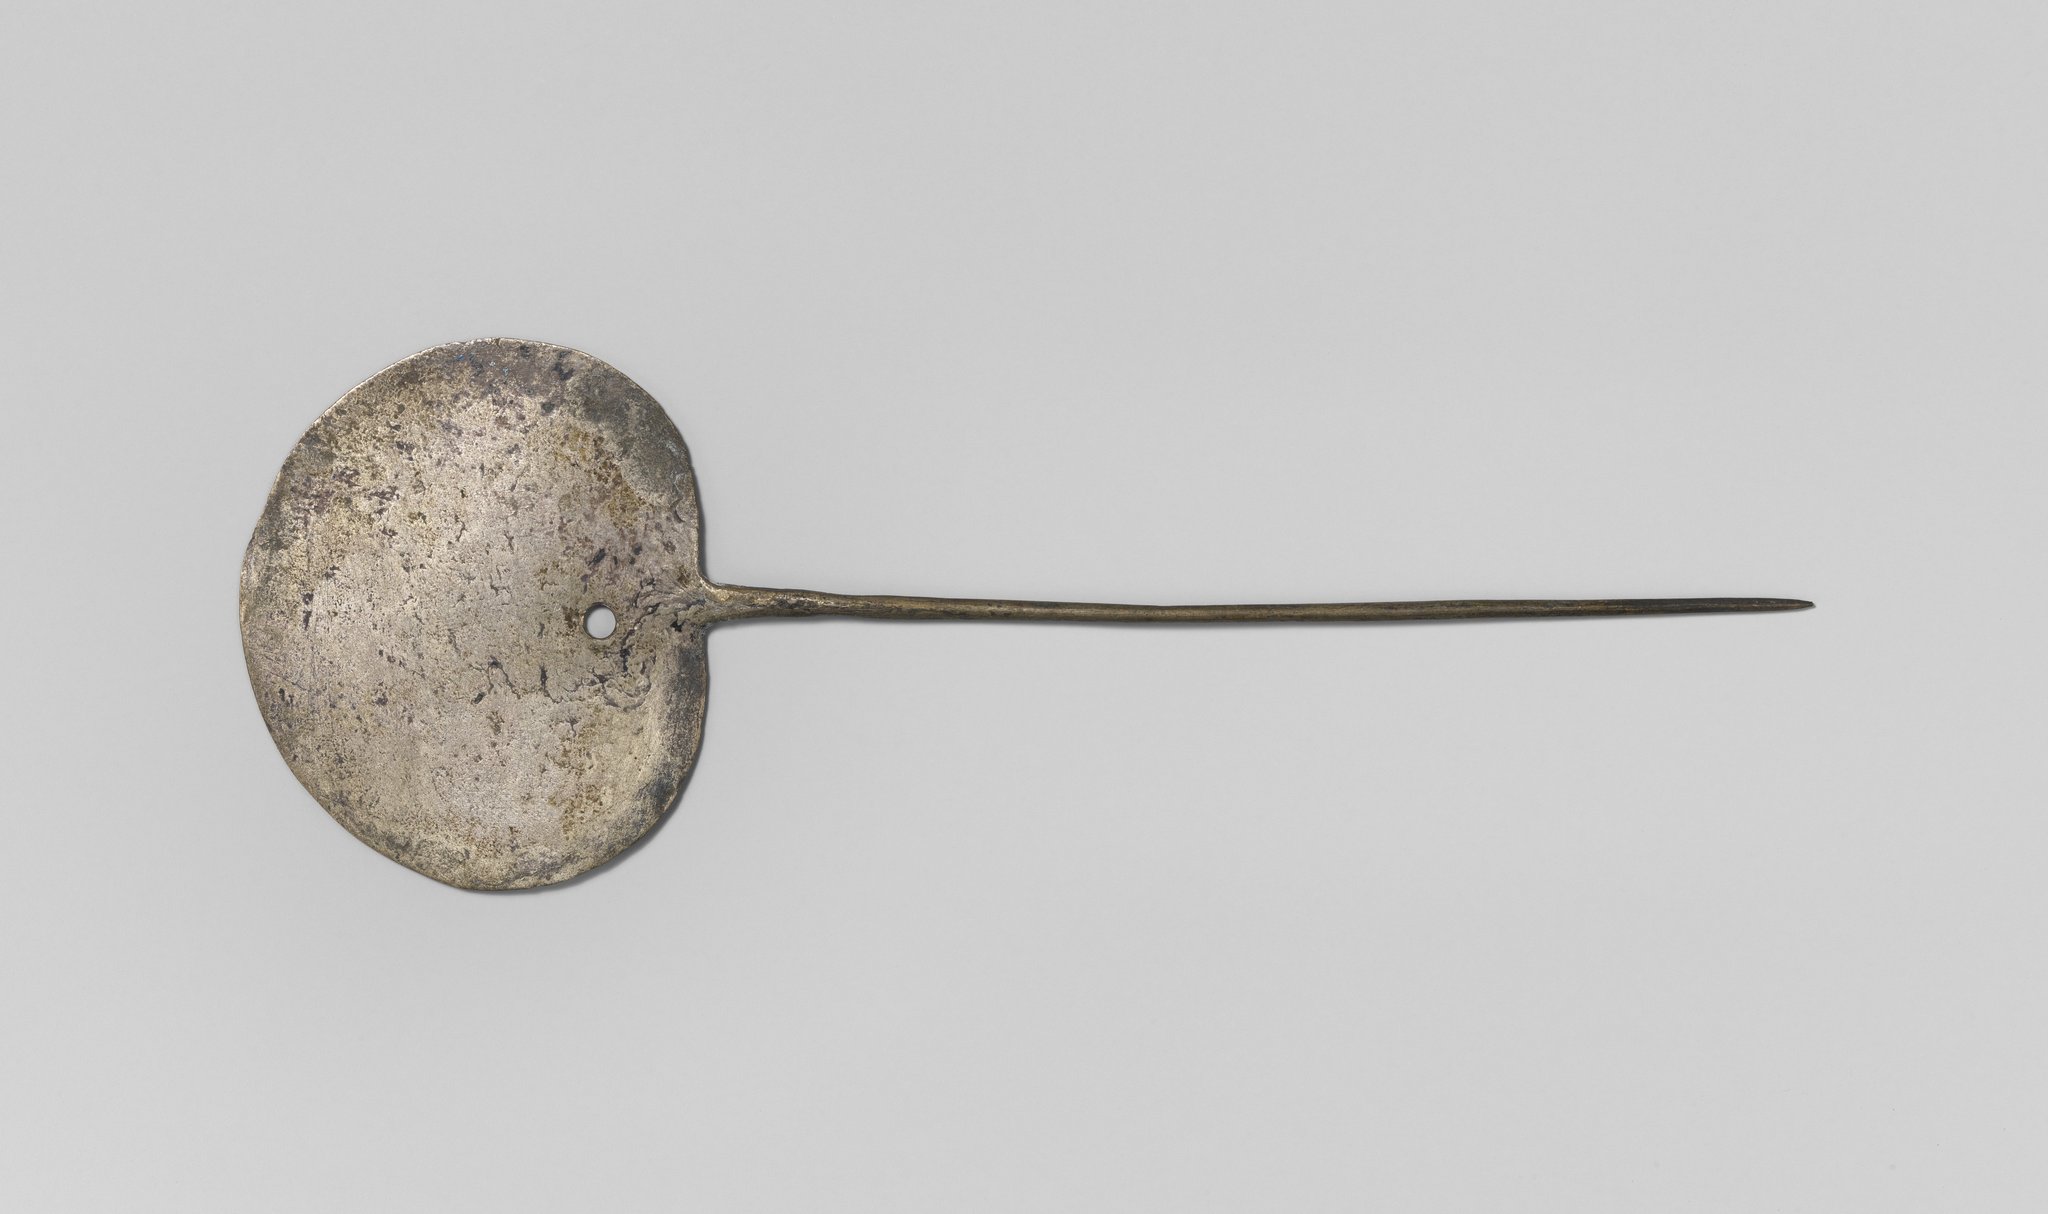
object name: pin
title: Tupu (pin)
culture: inca or wari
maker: wari or inca artist(s)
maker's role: artist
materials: silver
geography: peru